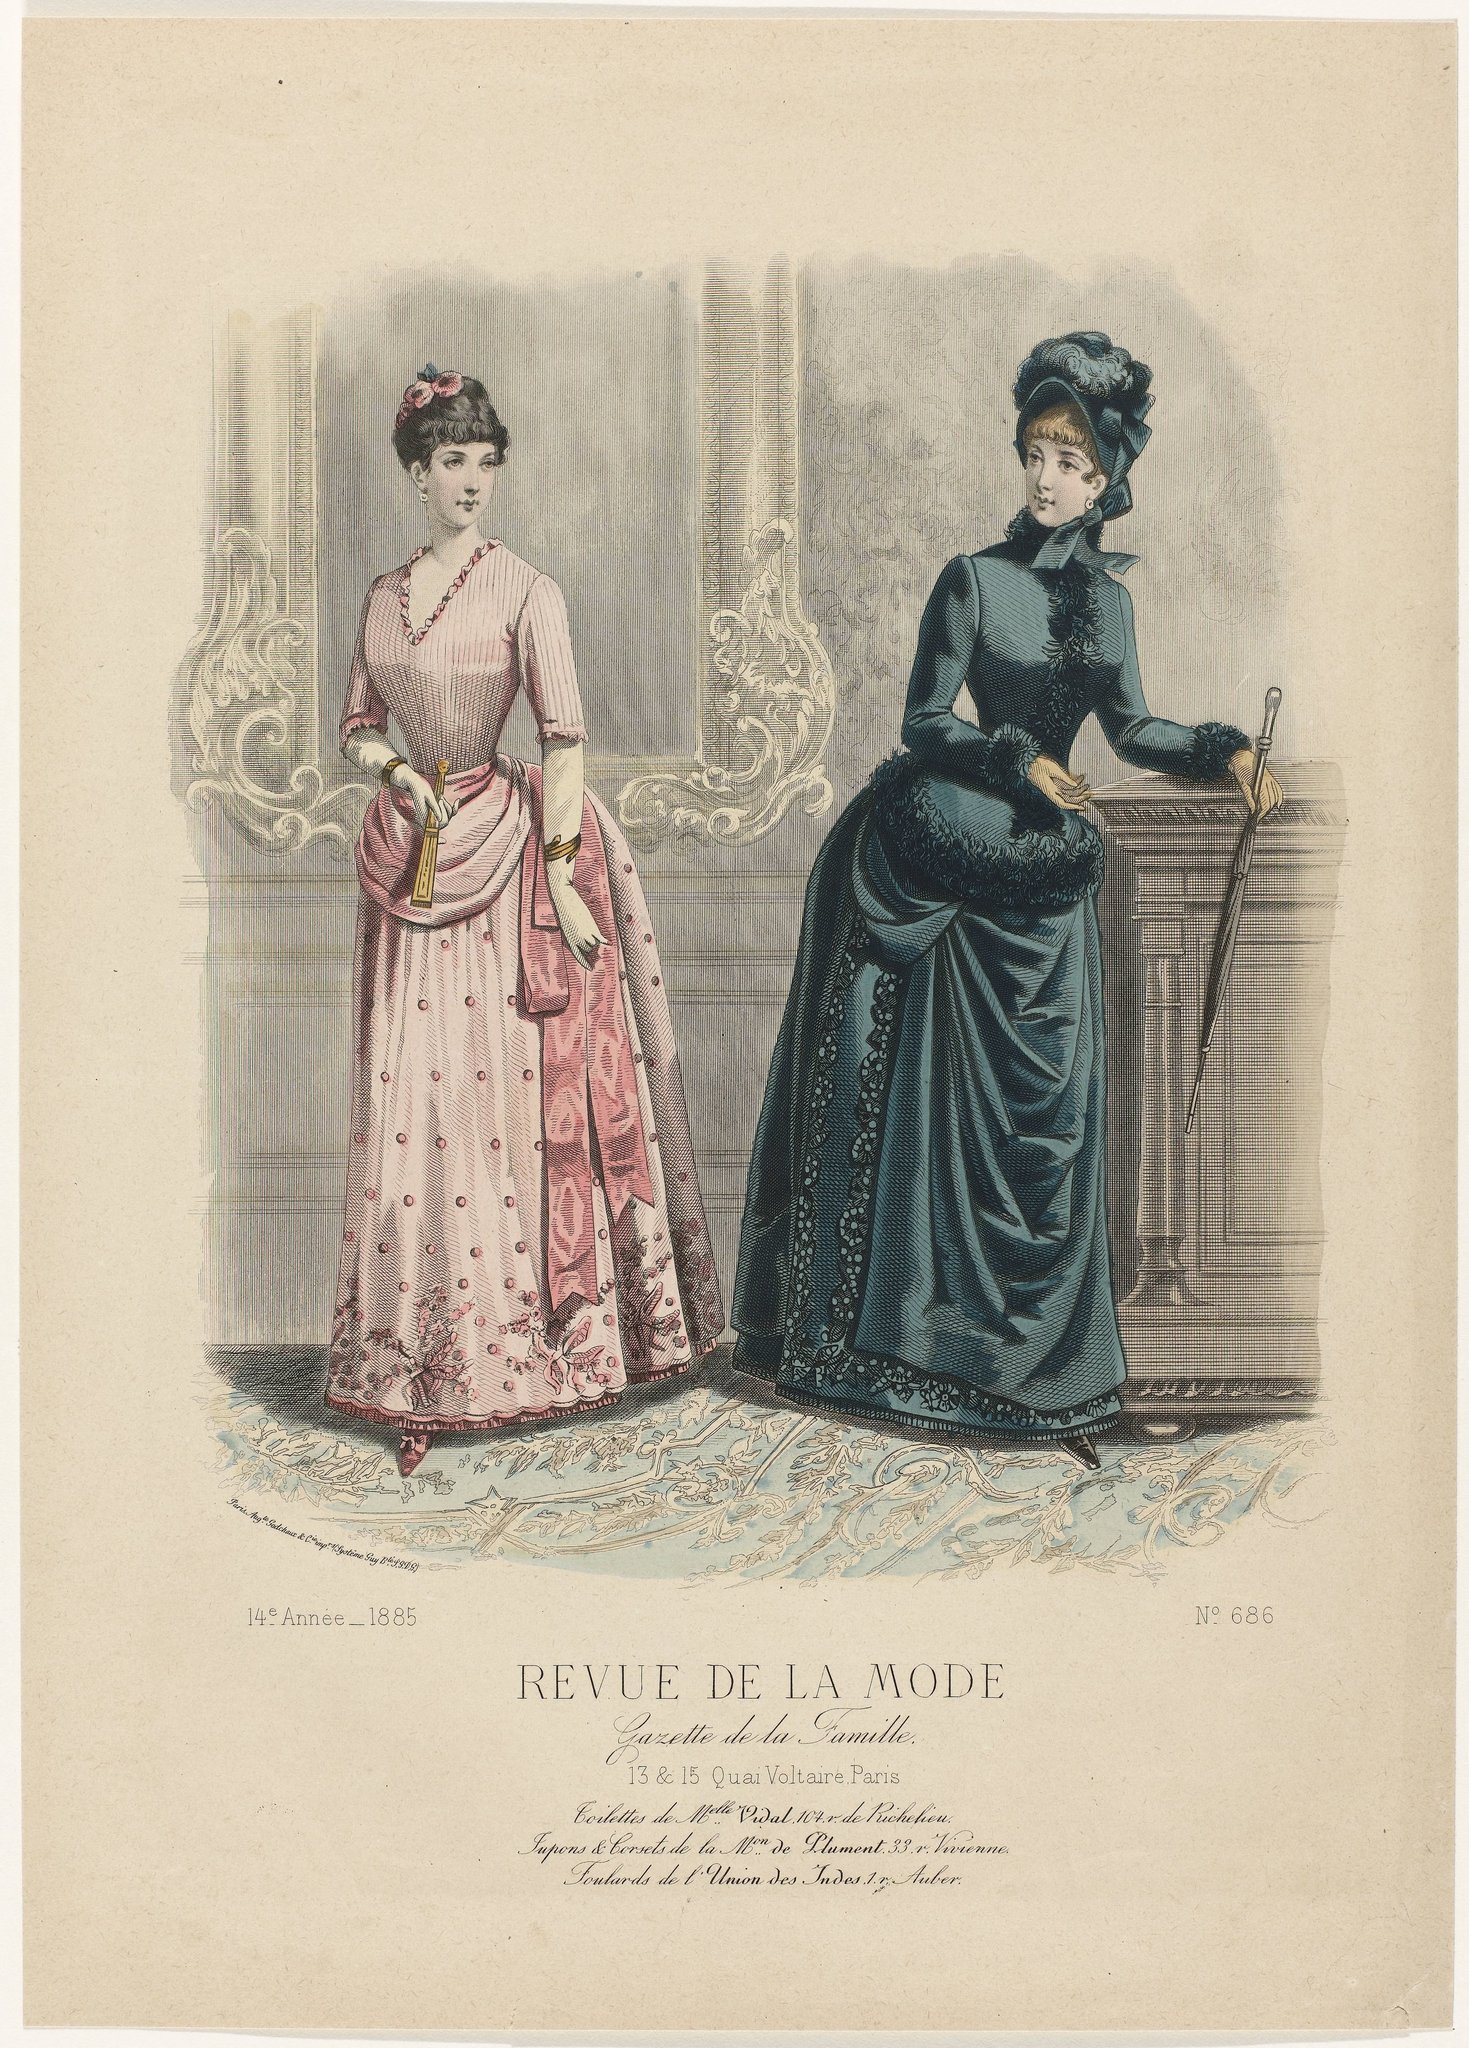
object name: fashion print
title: Revue de la Mode, Gazette de la Famille, dimanche 22 février 1885, 14e Année, No. 686: Toilettes de M.elles Vidal (...)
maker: Anonymous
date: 1885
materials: paper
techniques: engraving, hand coloring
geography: paris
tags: clothing for the upper part of the body (+ women's clothes), gloves, mittens (long gloves) (+ women's clothes), walking-stick, staff, cane (+ women's clothes), border, ribbon, braid (+ women's clothes), fashion plates, head-gear: hat (+ women's clothes), skirt (+ women's clothes), dress, gown (+ women's clothes), fan (+ women's clothes), bracelet, wristlet (+ women's clothes)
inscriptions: address: ‘13 & 15, Quai Voltaire, Paris’, caption: ‘Toilettes de M.elle Vidal, 104, r. de Richelieu. Jupons & Corsets de la M.on de Plument, 33, r. Vivienne. Foulards de l'Union des Indes, 1,r. Auber.’, title: ‘REVUE DE LA MODE / Gazette de la Famille’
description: Twee vrouwen in een interieur in japonnen van Vidal. Links: japon van roze 'surah', roze geborduurde tule en lint van 'faille', geschikt voor een jonge vrouw. Rechts: kostuum van effen groen laken, versierd met applicaties van fluwelen bloemen en veren rand. Met enkele regels reclametekst voor verschillende producten. Prent uit het modetijdschrift Revue de la Mode (1872-1913). Uitgebreide beschrijving van de kleding op pagina 61 "PLANCHE COLORIÉE".